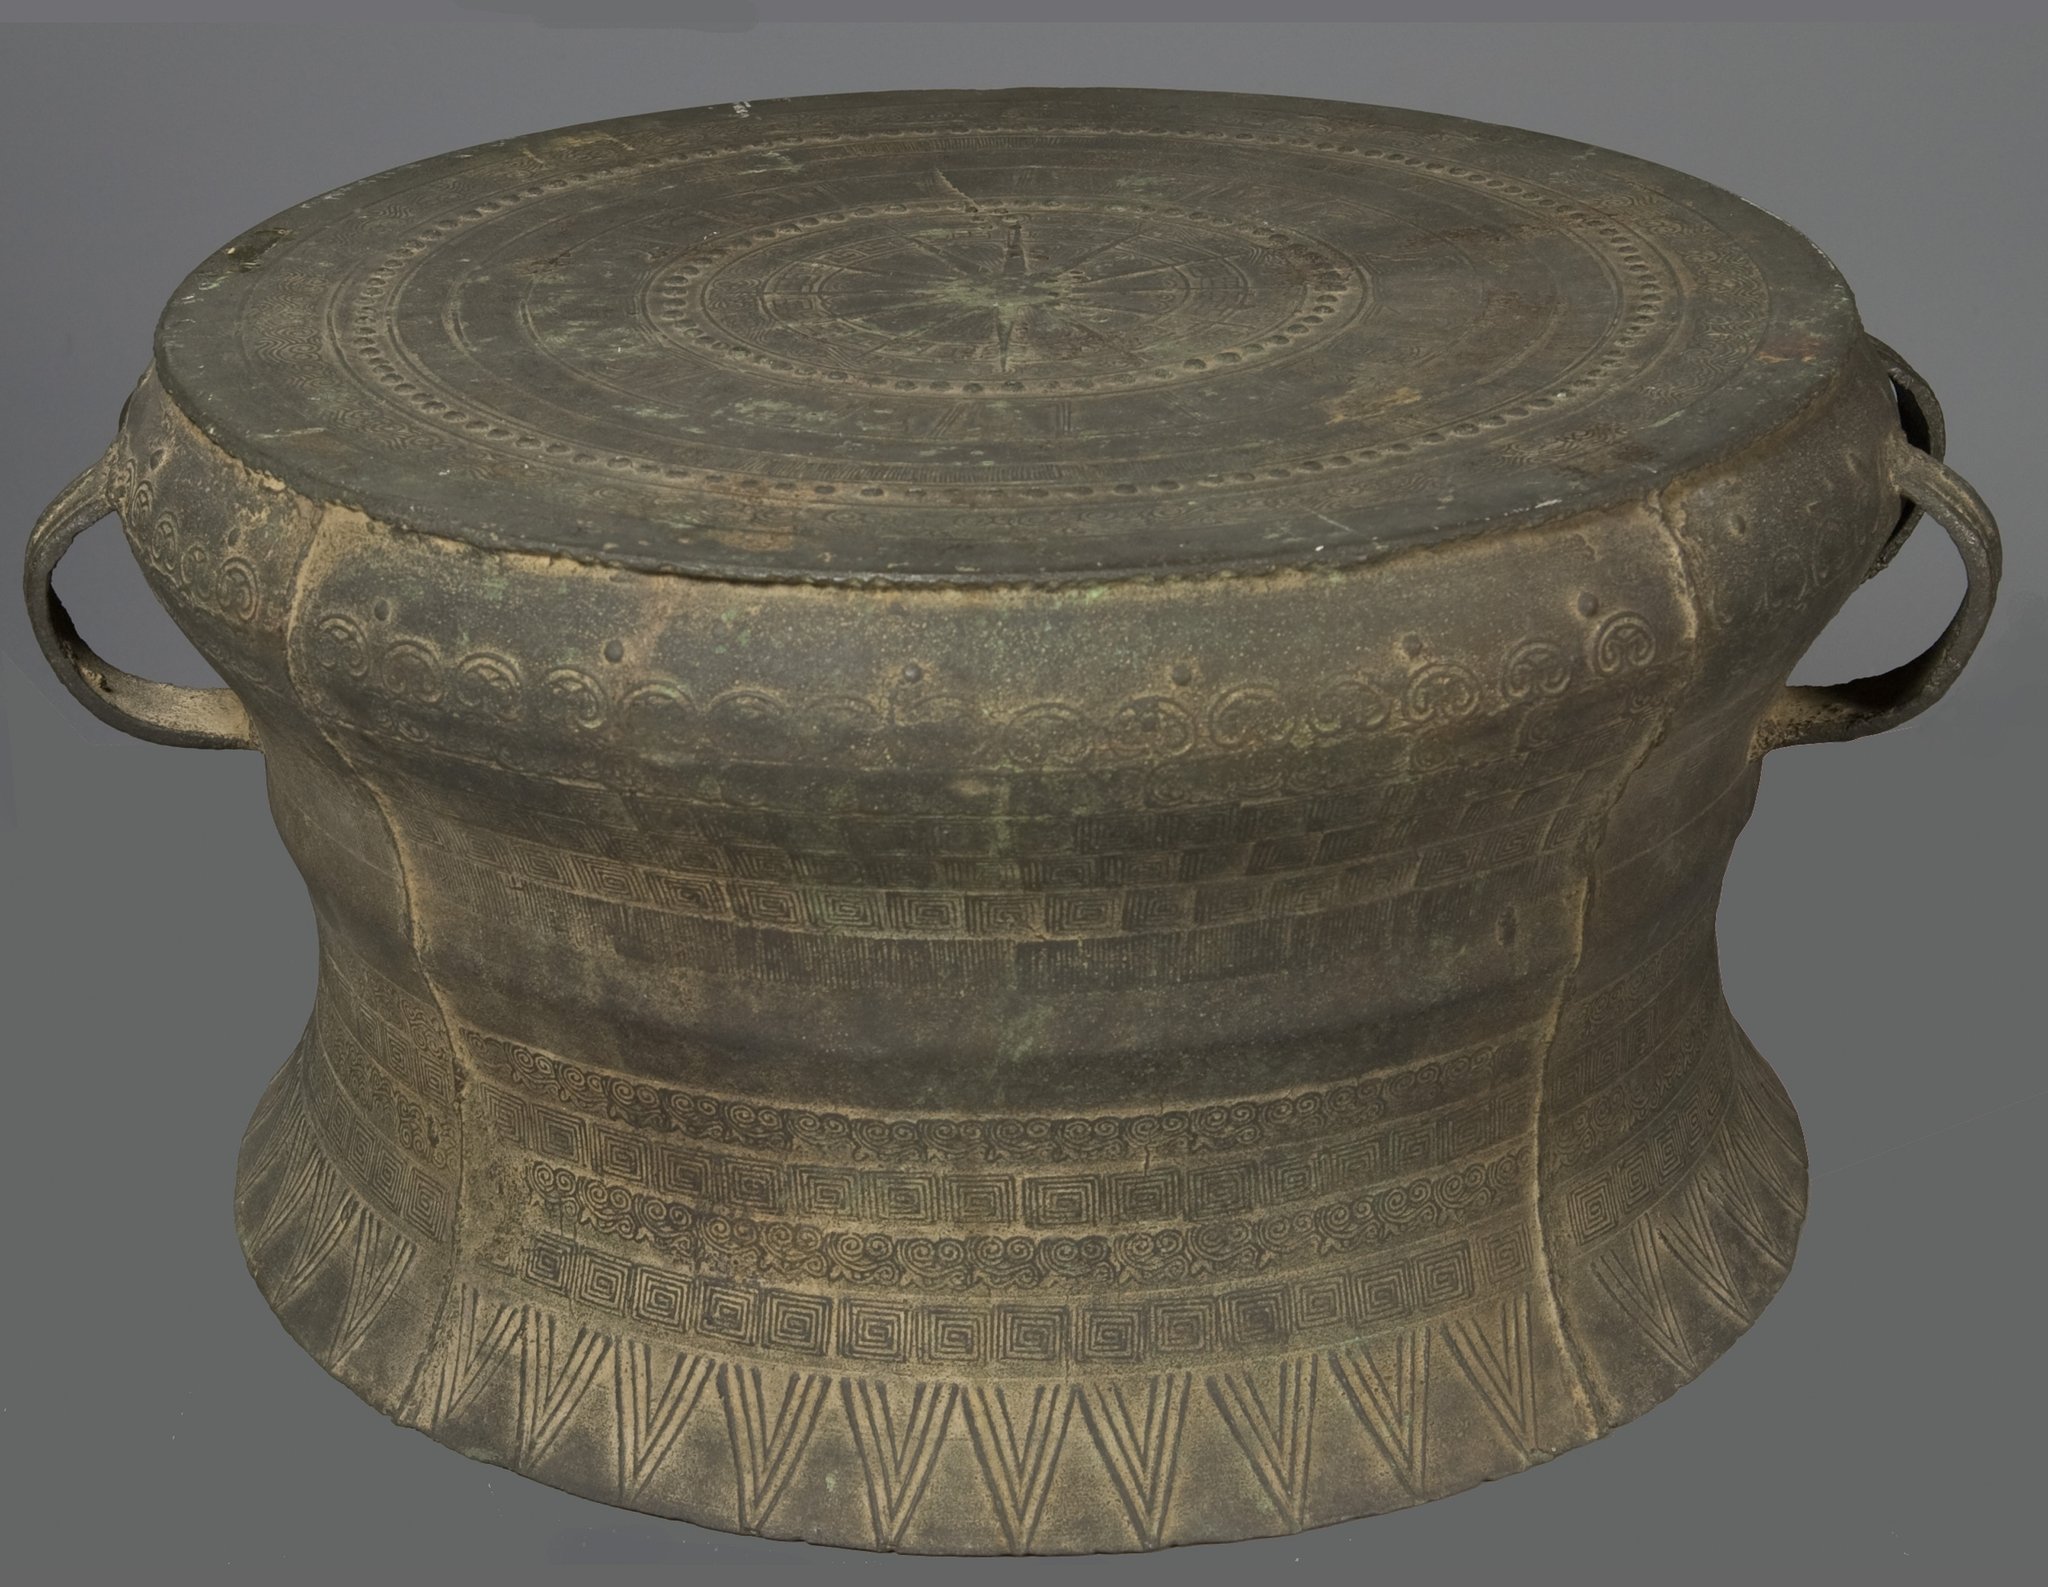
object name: tonggu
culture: chinese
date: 1889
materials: bronze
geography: china